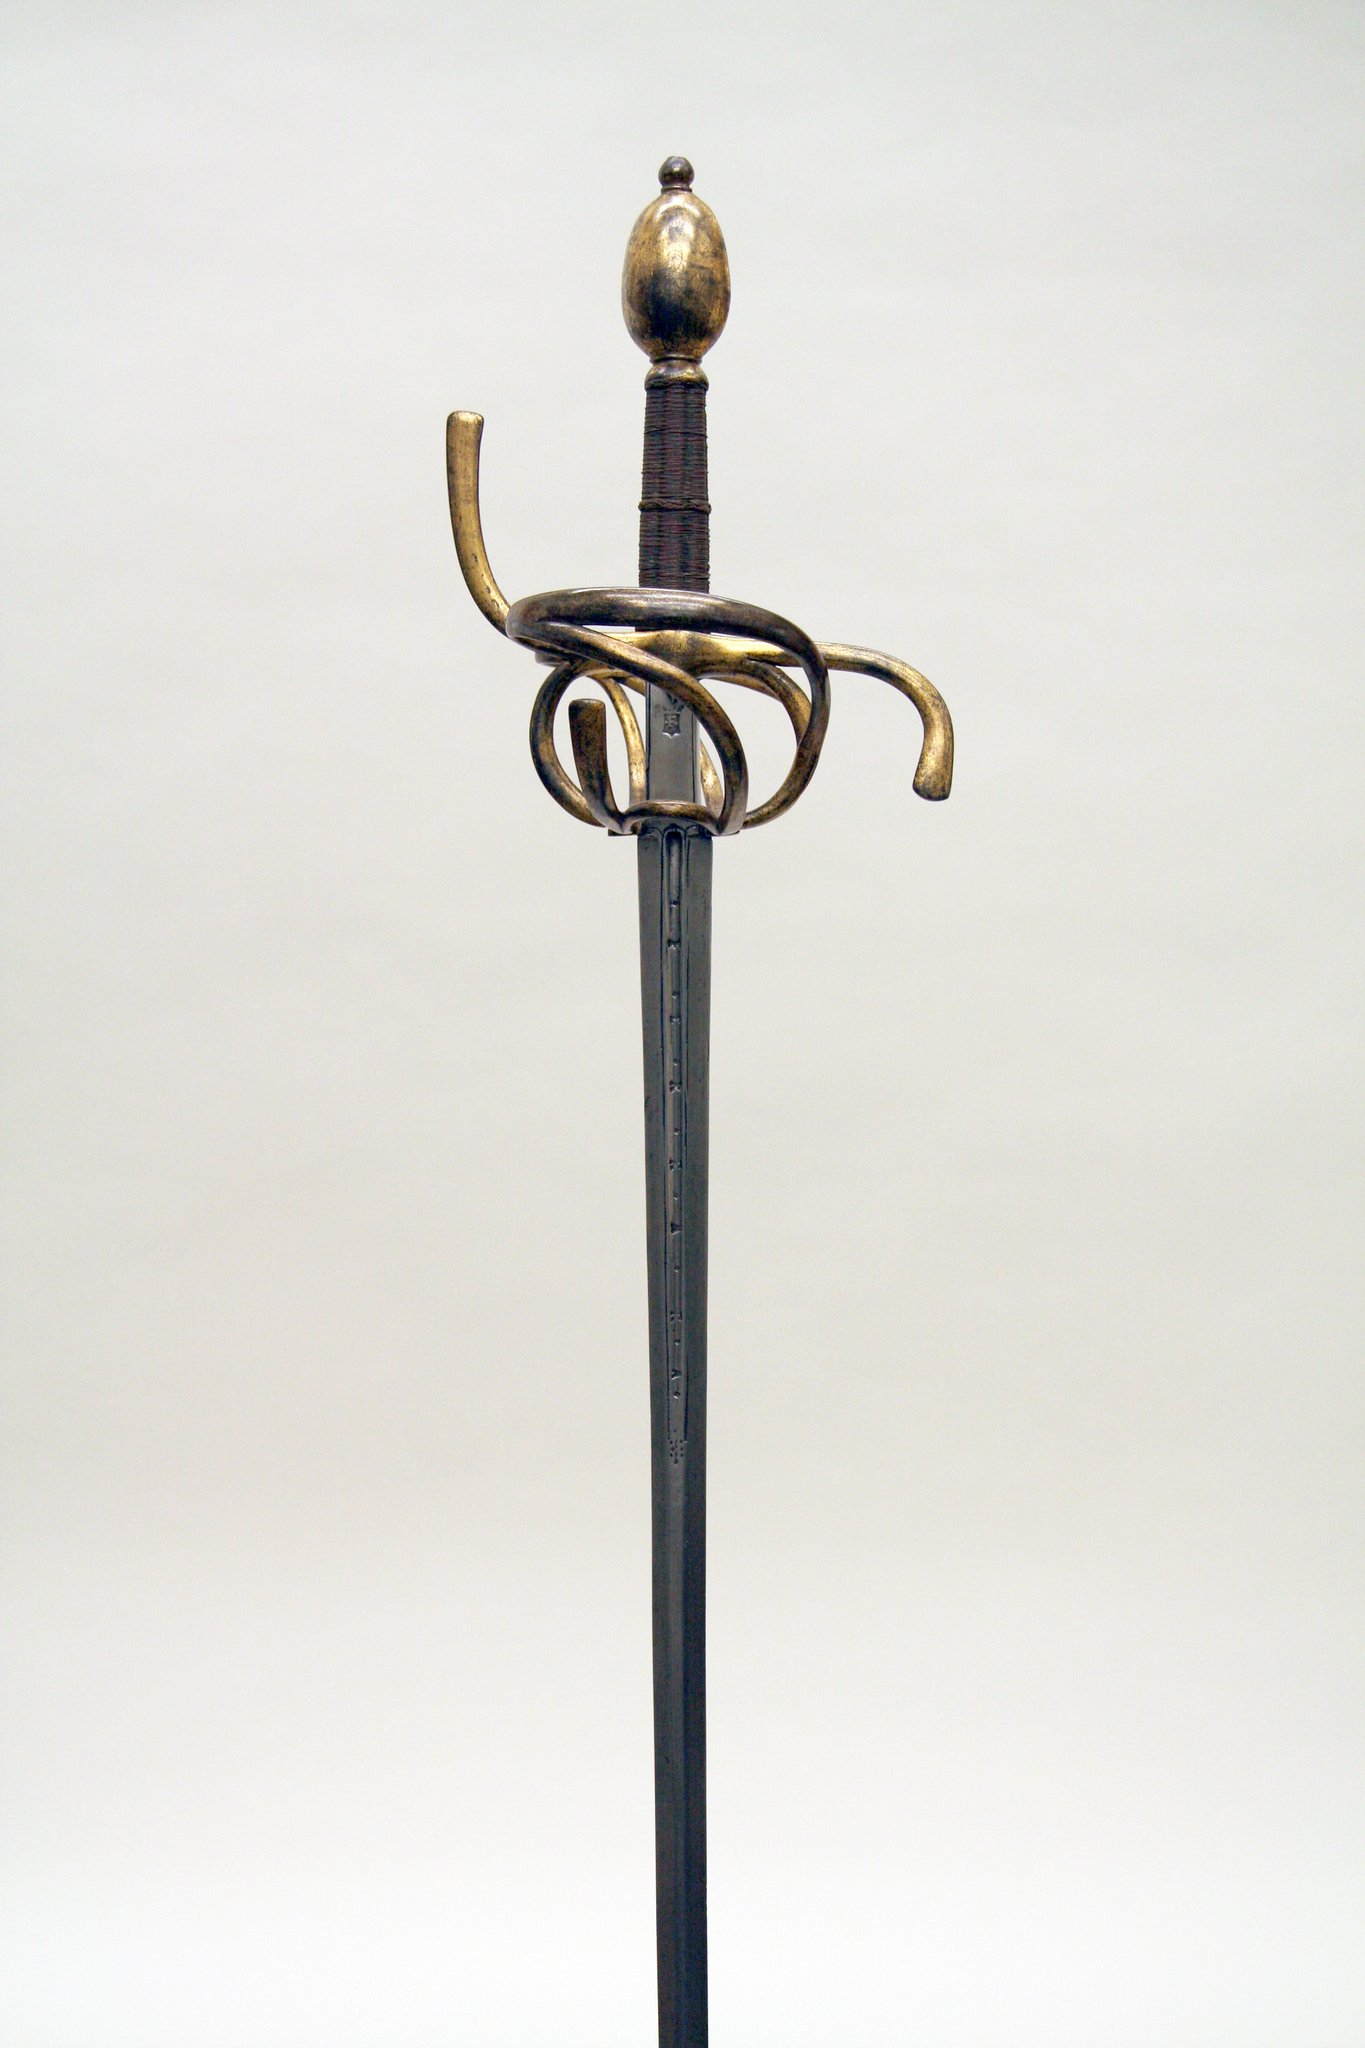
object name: rapier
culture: german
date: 1600-1620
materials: copper, gold, steel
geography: germany